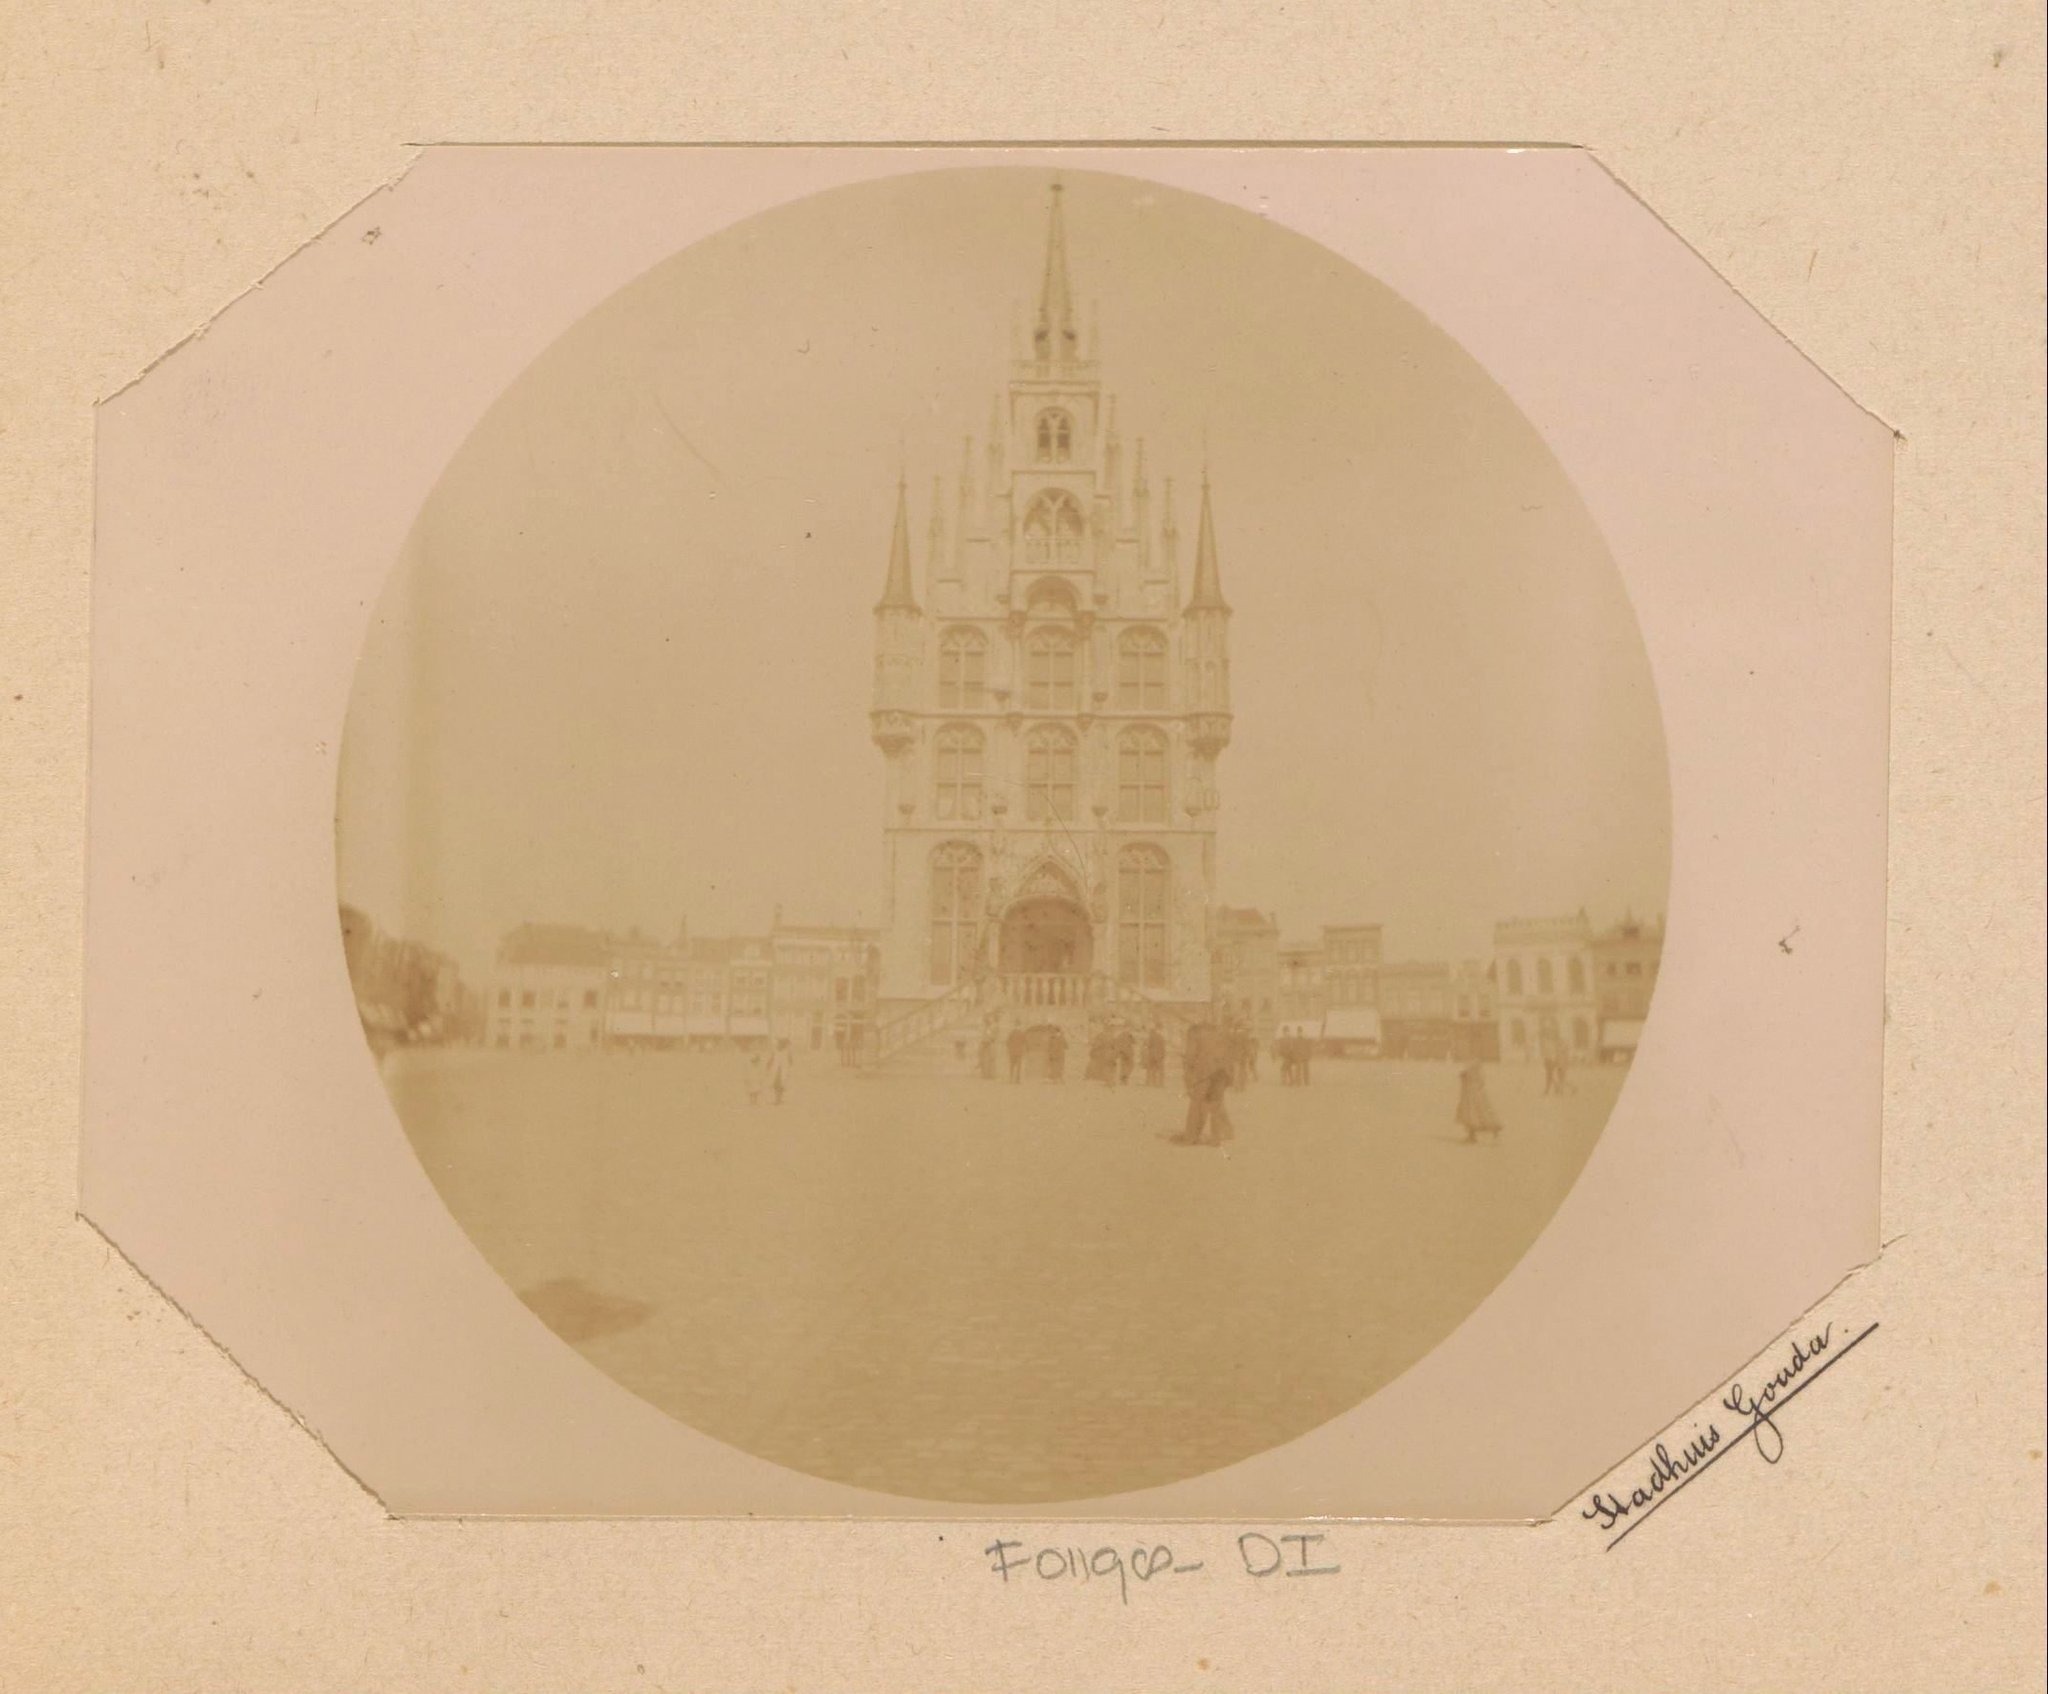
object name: album leaf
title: Gezicht op het stadhuis van Gouda, excursie van de Openbare Handelsschool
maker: willem frederik piek jr.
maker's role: fotograaf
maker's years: 1874-1954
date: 1889-1893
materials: paper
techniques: gelatin silver print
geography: gouda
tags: townhall